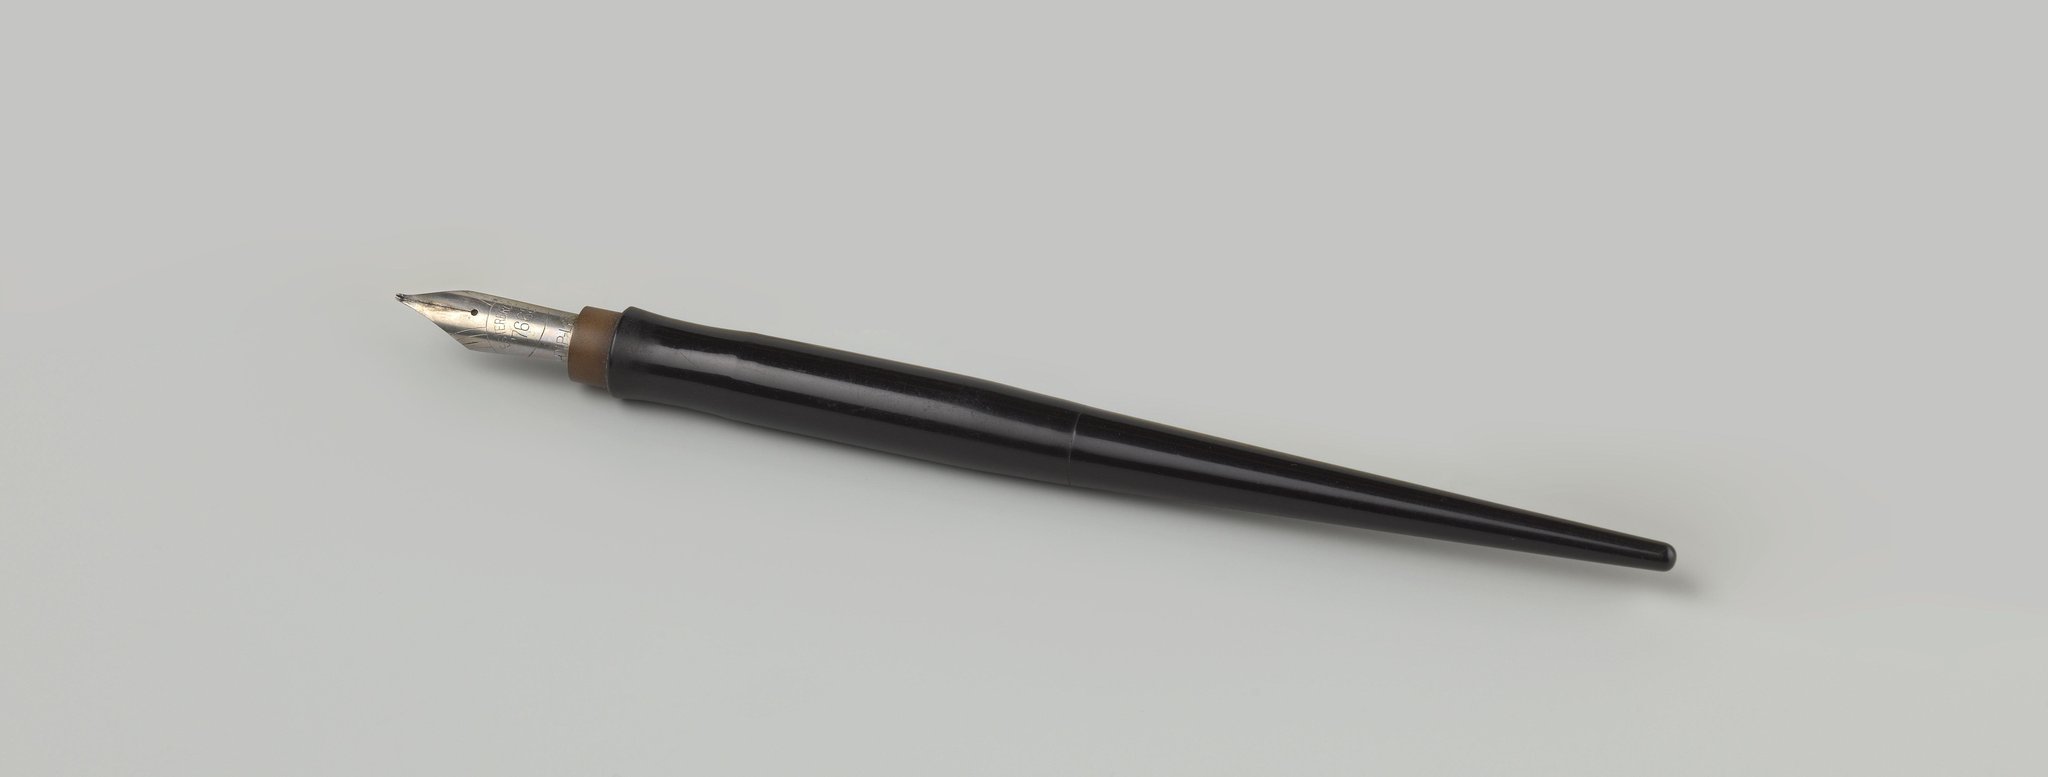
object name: ribbon material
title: Pen waarmee Mr D.U. Stikker het NAVO-verdrag ondertekende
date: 1949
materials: plastic, silk, silver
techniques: casting, striking, weave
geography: united states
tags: dirk uipko stikker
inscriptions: mark: ‘Esterbrook / DIP-LESS / MADE IN USA’, inscription: ‘MET DEZE PEN WERD HET ATLANTISCH PACT GETEEKEND DOOR MR. D.U. STIKKER OP 4 APRIL 1949’, mark: ‘ESTERBROOK / 7668 / DIP-LESS’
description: Pen waarmee Mr D.U. Stikker het NAVO-verdrag ondertekende. Zwarte pennenhouder met zilveren punt, aan het andere eind toelopend. Is in twee helften uit elkaar te schroeven, waardoor het inktreservoir geopend wordt. Het witte lint met opschrift (NG-698-9-D) zit vastgeknoopt aan het rood-wit-blauwe lint van het boek (NG-698-9-A).